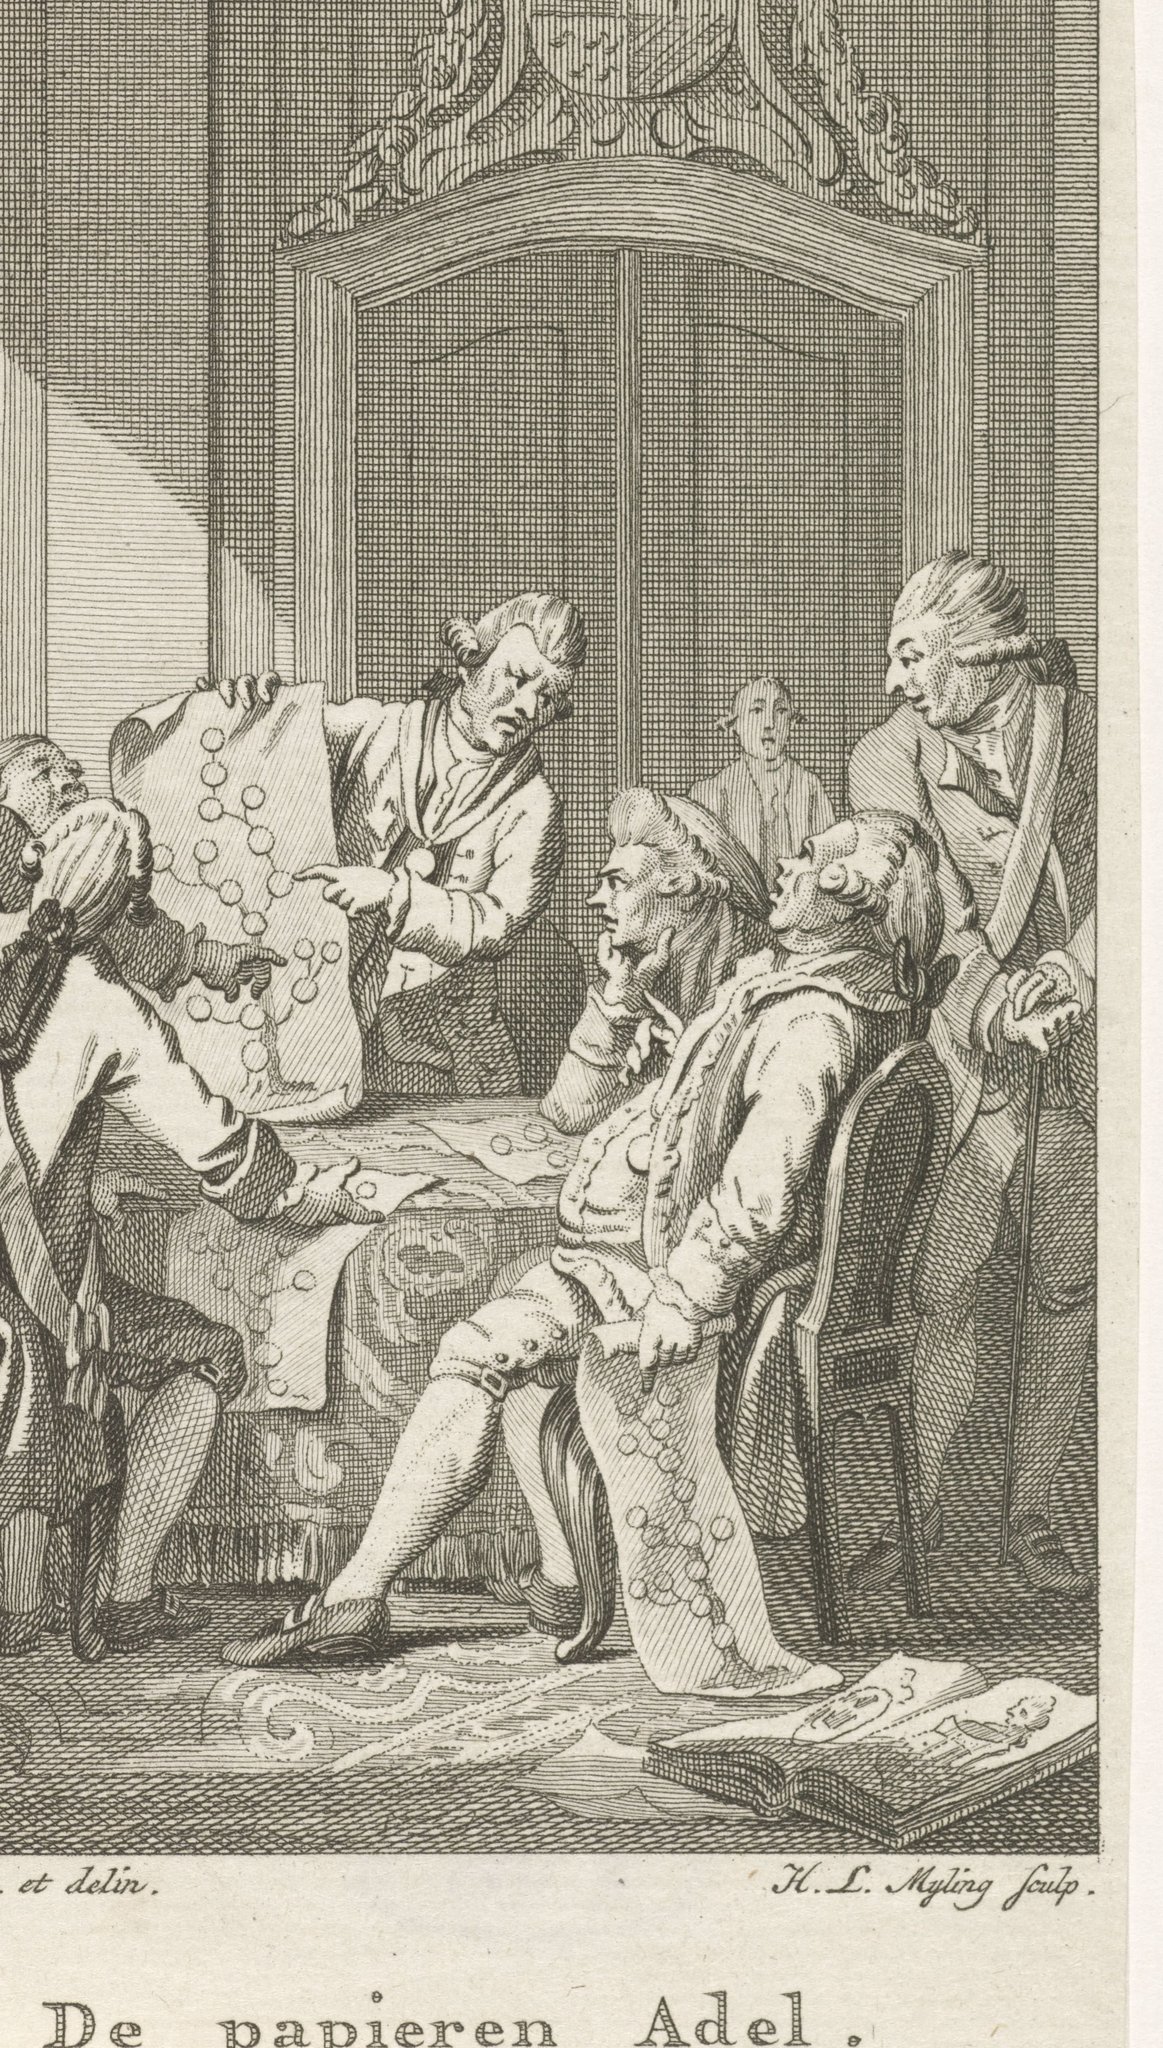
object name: print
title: Mannen in gesprek over hun adelijke afstamming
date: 1777-1821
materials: paper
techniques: engraving, etching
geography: netherlands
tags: family lineage, pedigree, genealogical tree or table, table, debate, discussion (~ meeting), armorial bearing, heraldry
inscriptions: collector's mark: Lugt 2228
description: Mannen rond een tafel voeren een discussie over adellijke titels, terwijl ze op een papier wijzen, waarop een stamboom is afgebeeld. Op de grond een boek met wapenschilden.